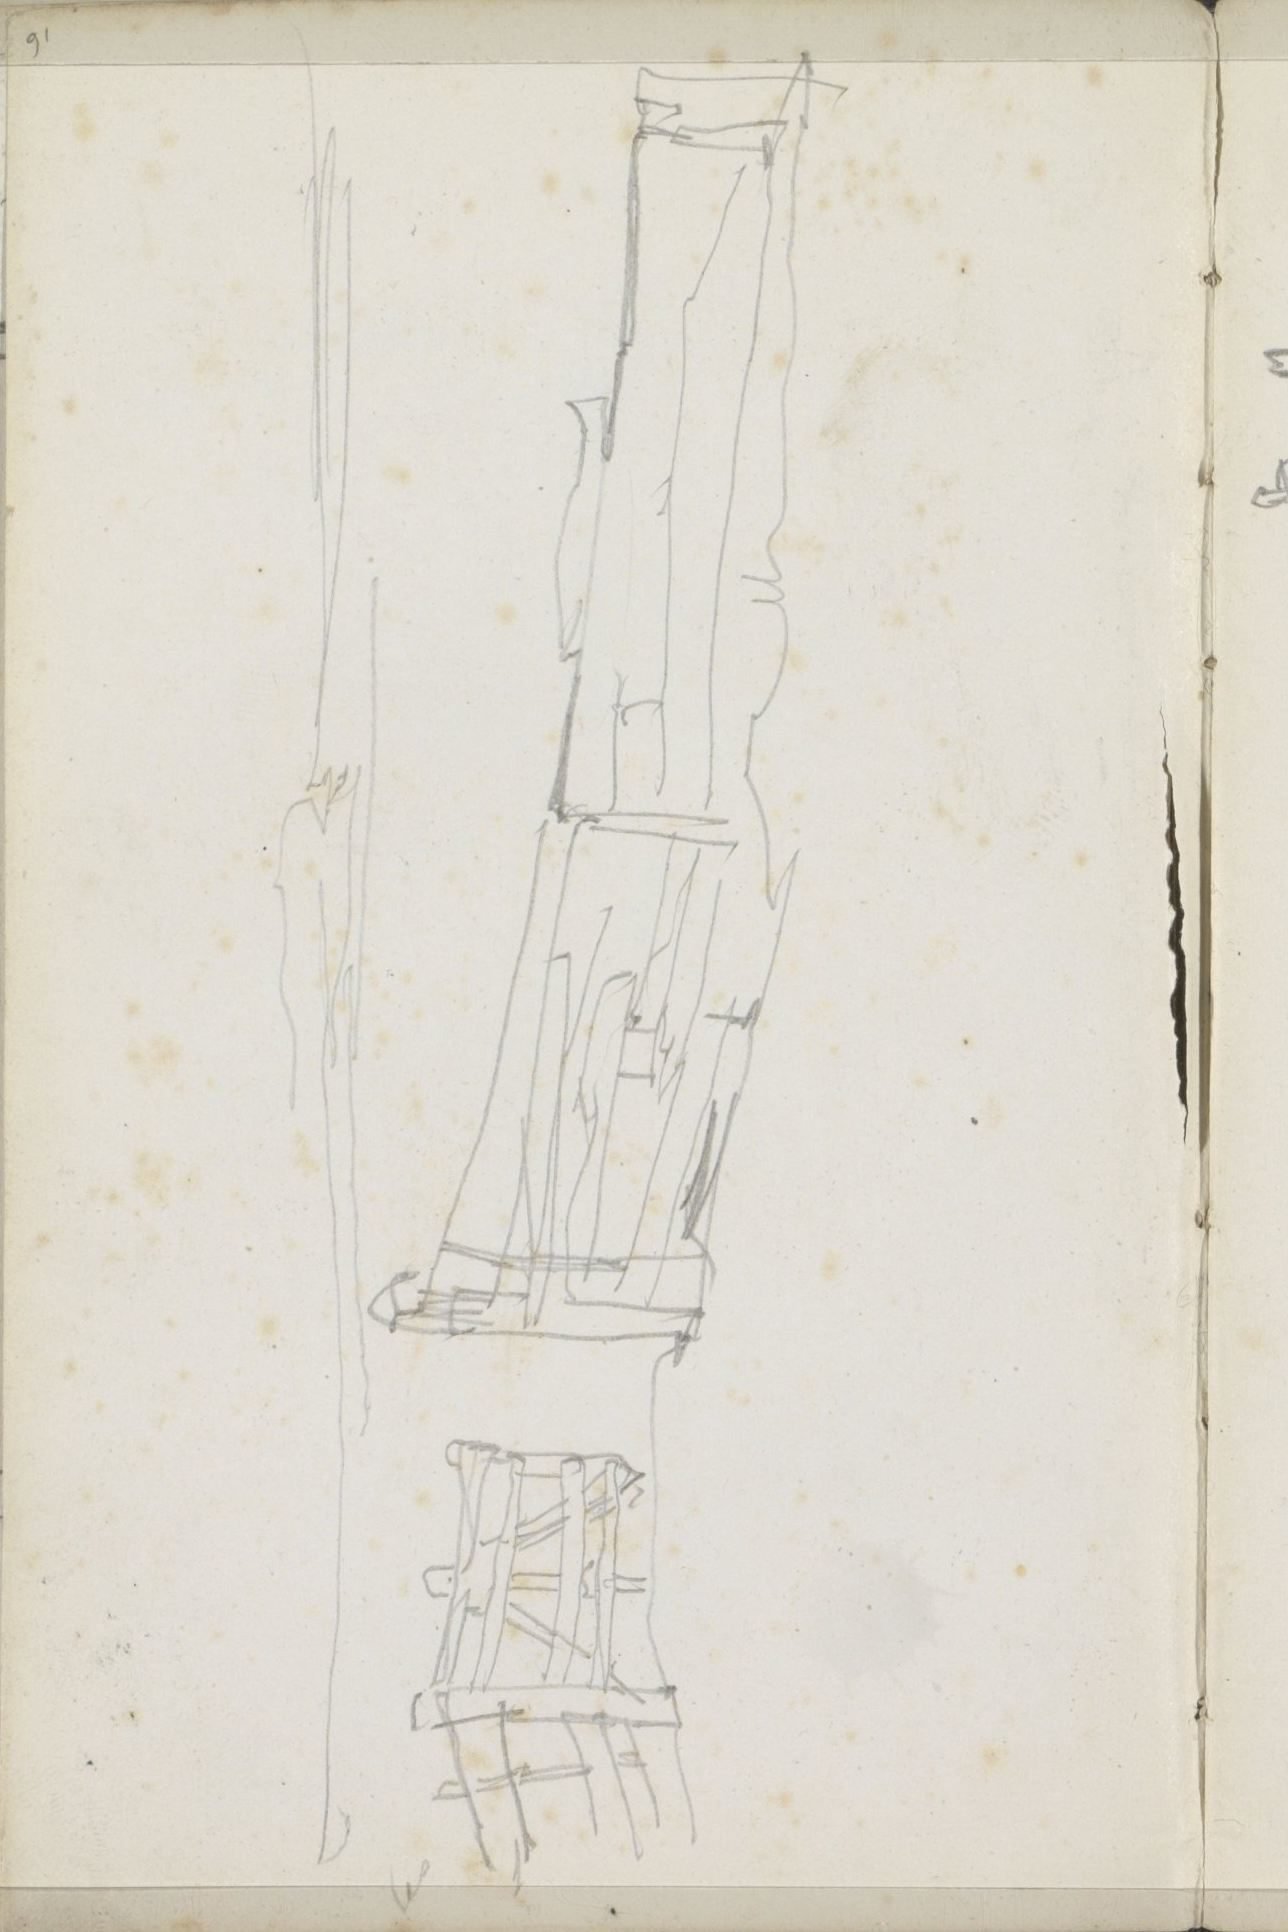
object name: sketchbook leaf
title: Landschap met een hek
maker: george hendrik breitner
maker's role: draughtsman, painter, print maker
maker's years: 1857-1923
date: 1880-1882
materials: paper, pencil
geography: south holland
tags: landscapes, fence, wall, paling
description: Pagina 91 uit een schetsboek met 72 bladen.